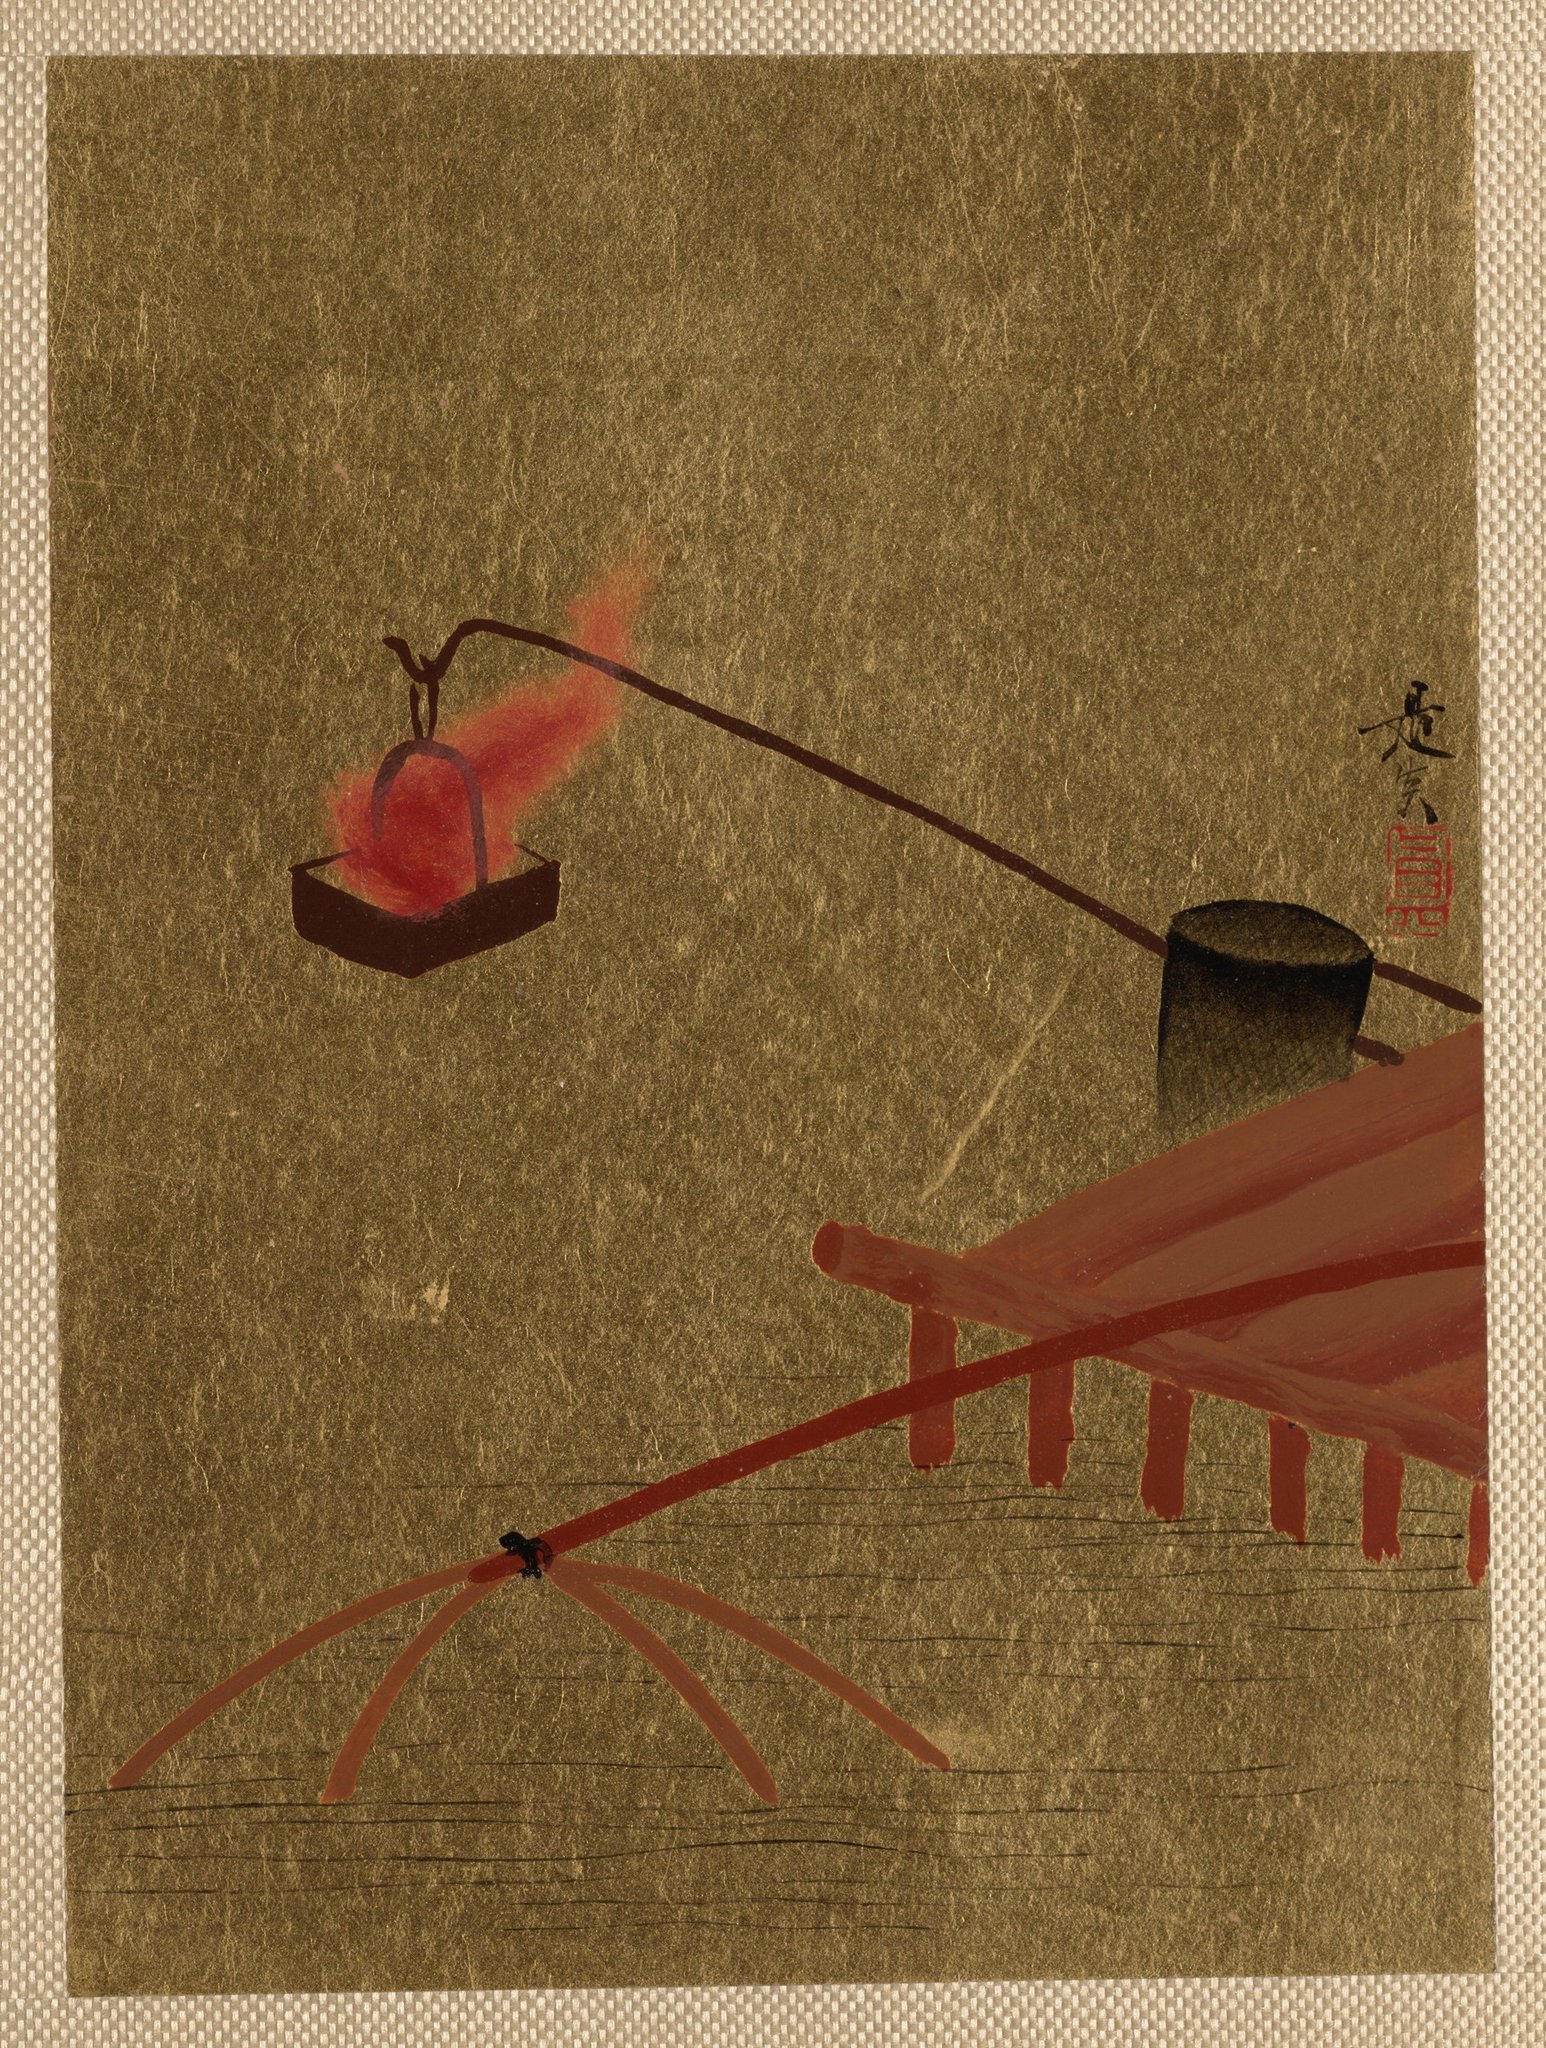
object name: album leaf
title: Fire Basket Suspended from Dock over a Fish Net in the Water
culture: japanese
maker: shibata zeshin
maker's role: artist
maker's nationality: japanese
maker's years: 1807-1891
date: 1807-1868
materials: gold, lacquer, paper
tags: docks,fire